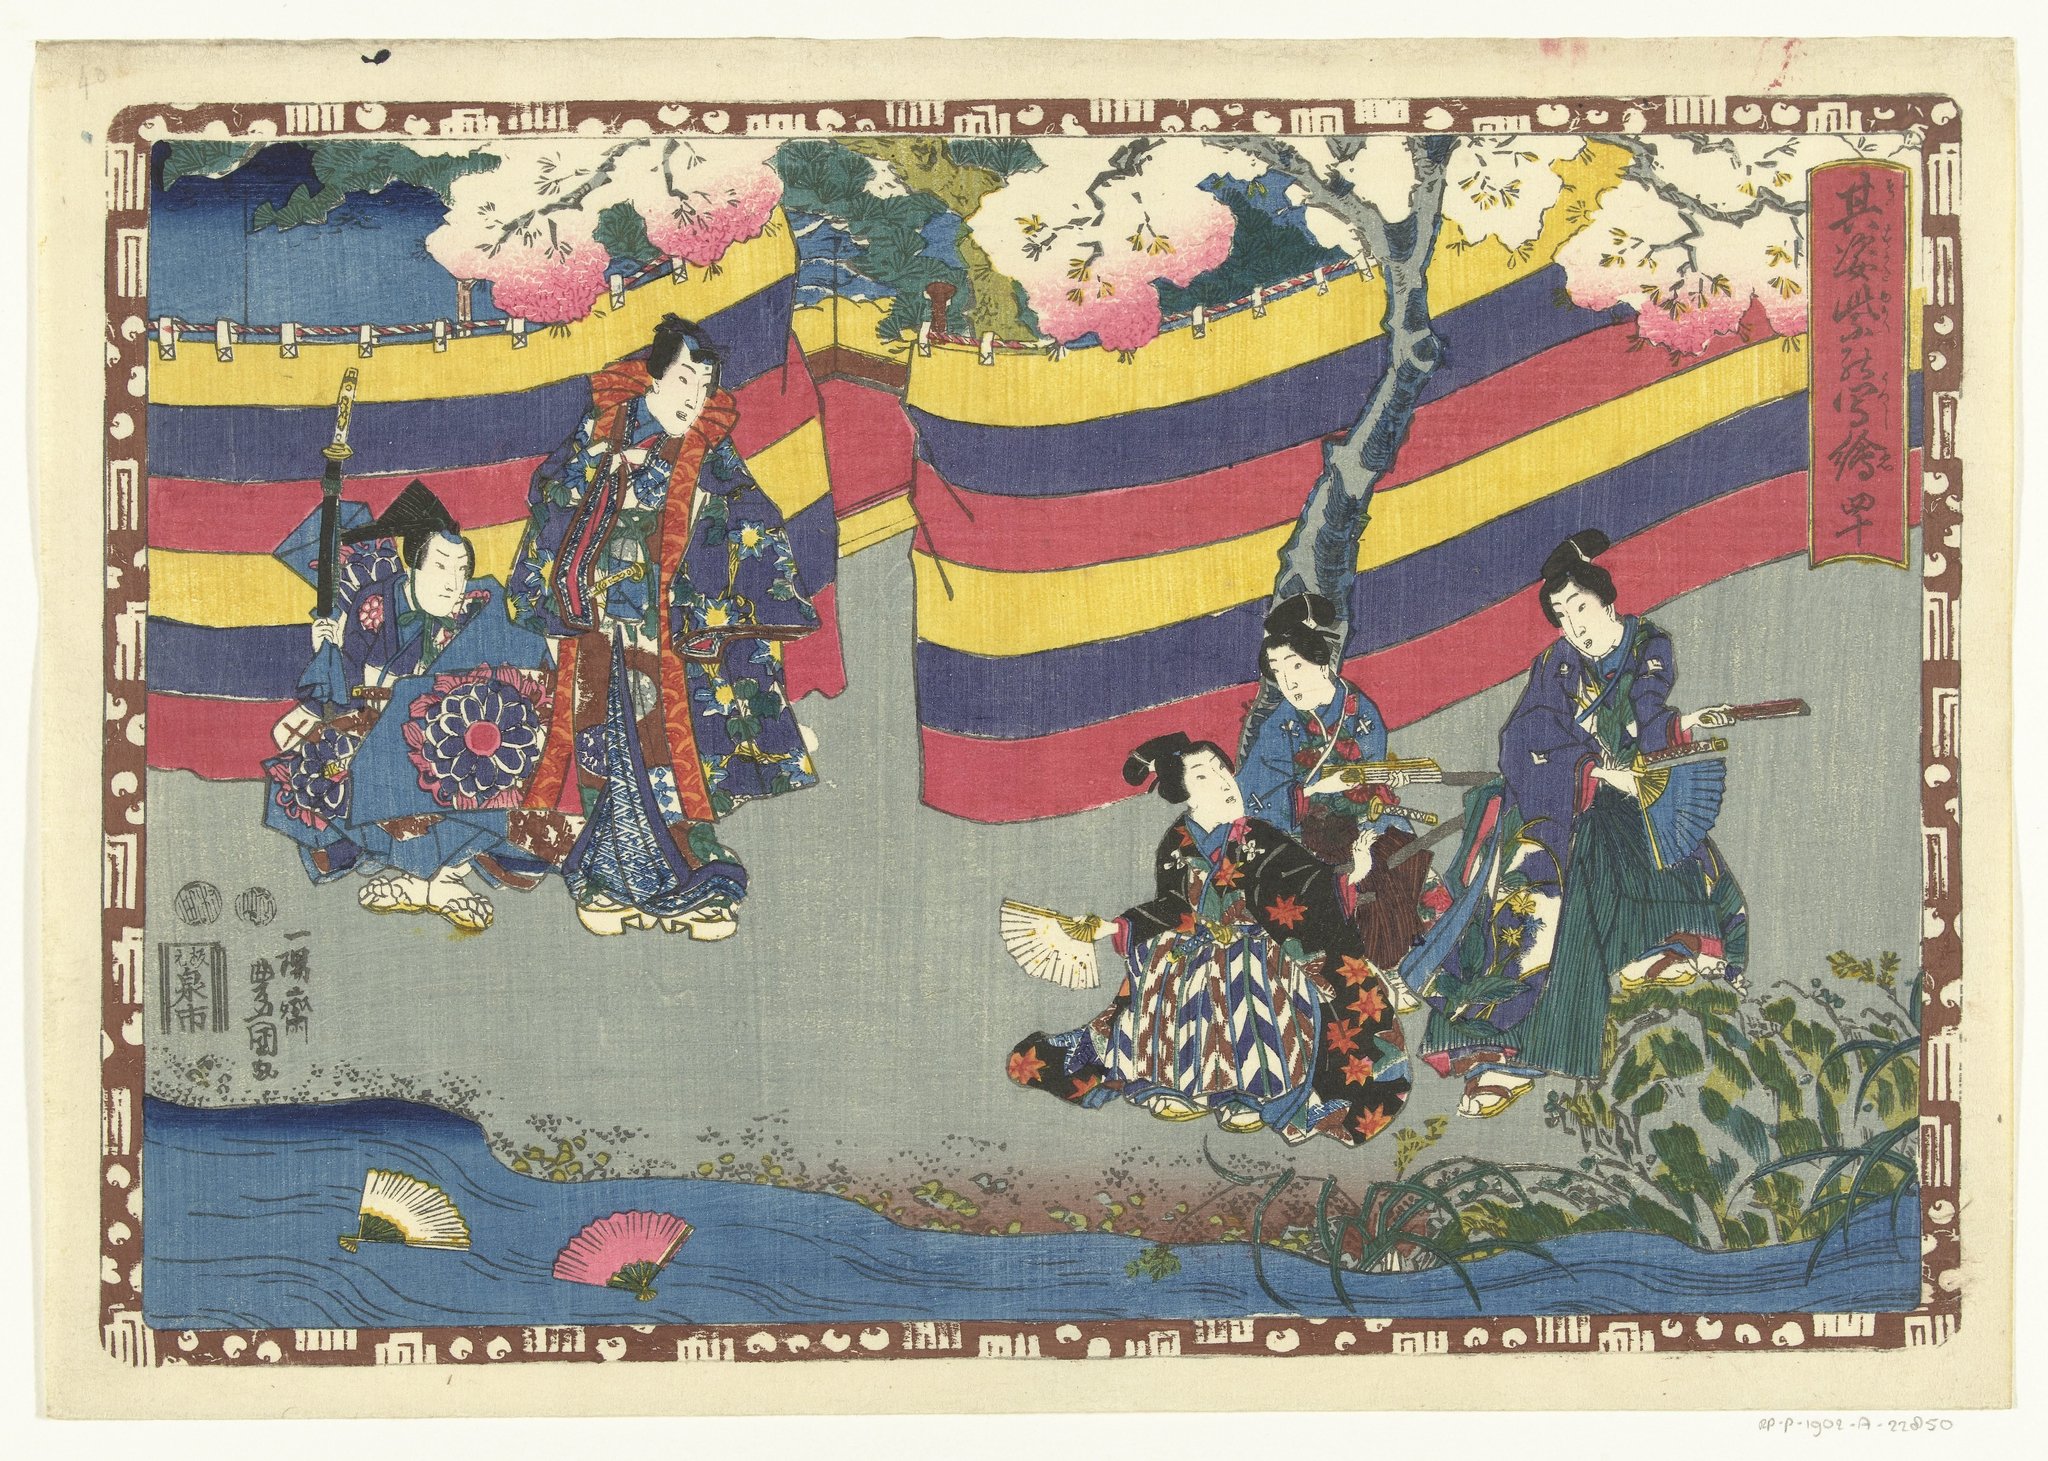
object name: print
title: Sono sugata Hikaru no utsushi-e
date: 1851-1853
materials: paper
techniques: woodcut, nishiki e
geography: japan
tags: trees, open-air recreation, river (+ landscape with figures, staffage)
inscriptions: collector's mark: Lugt 2228